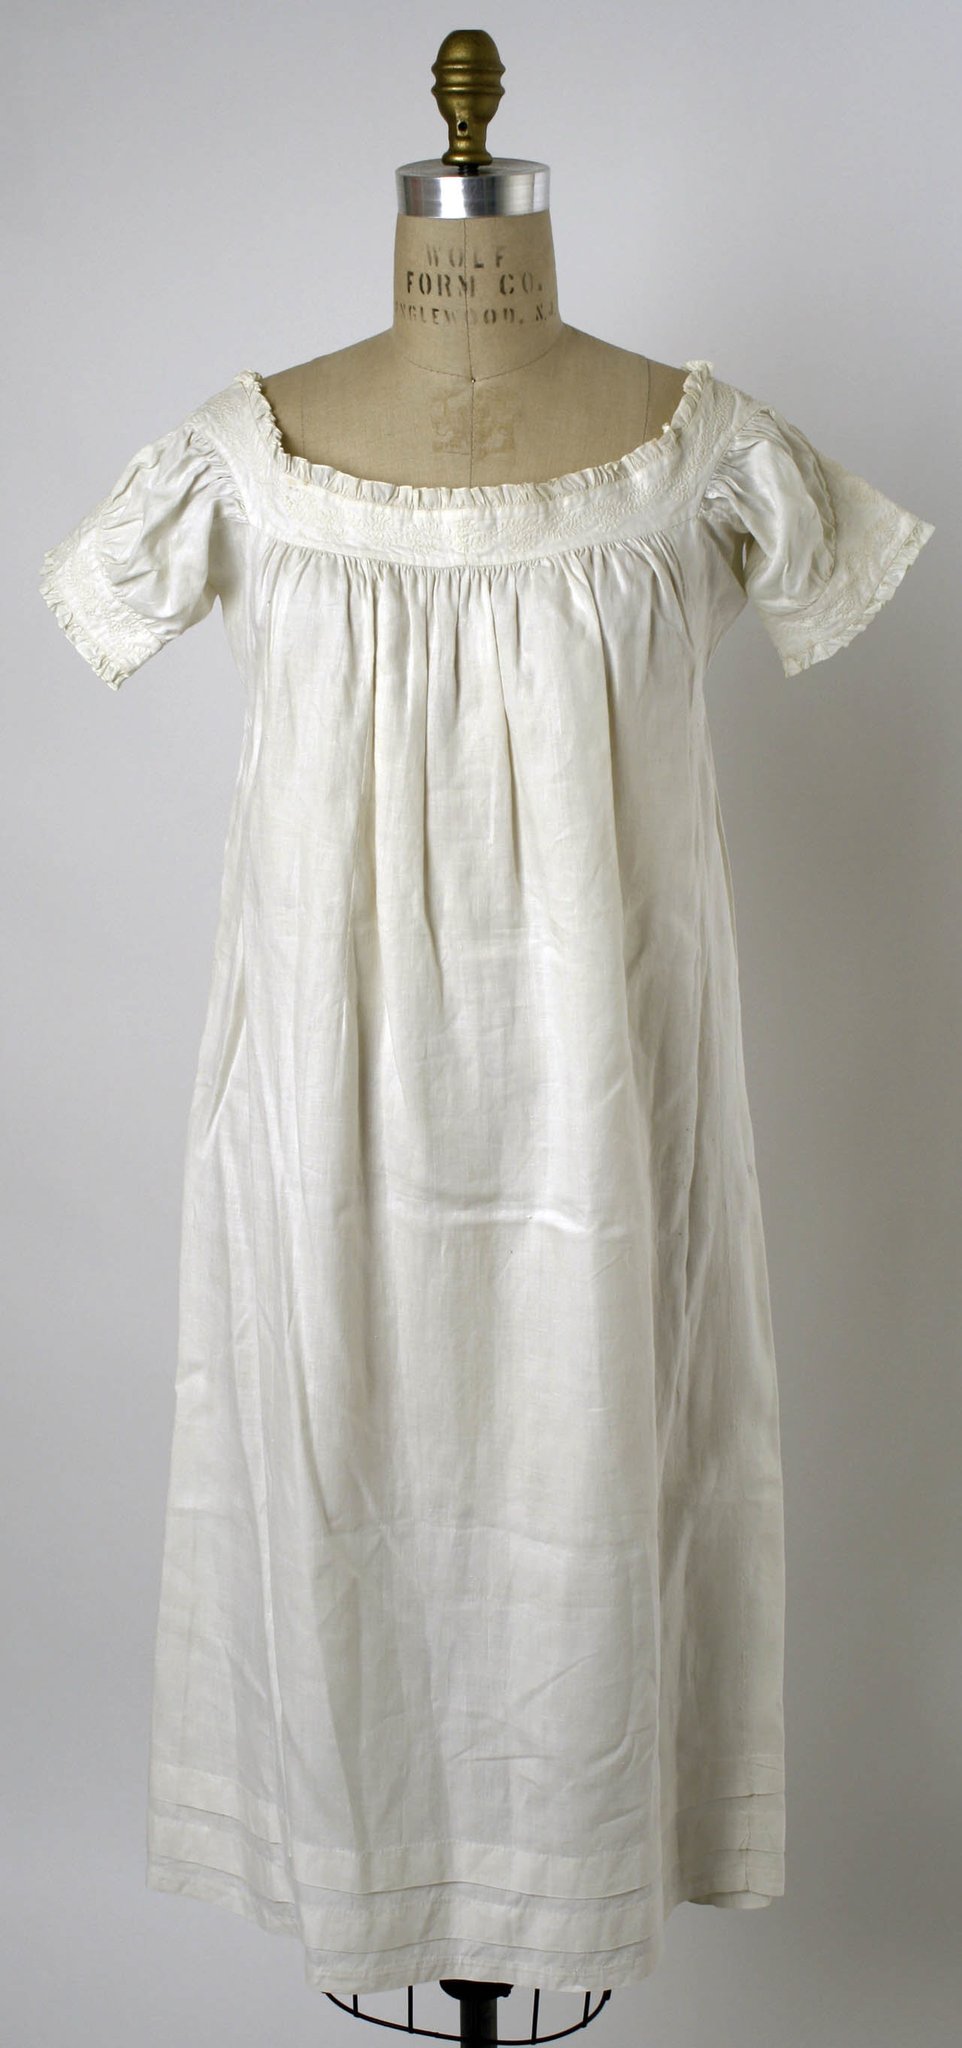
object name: chemise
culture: american or european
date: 1830-1839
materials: linen